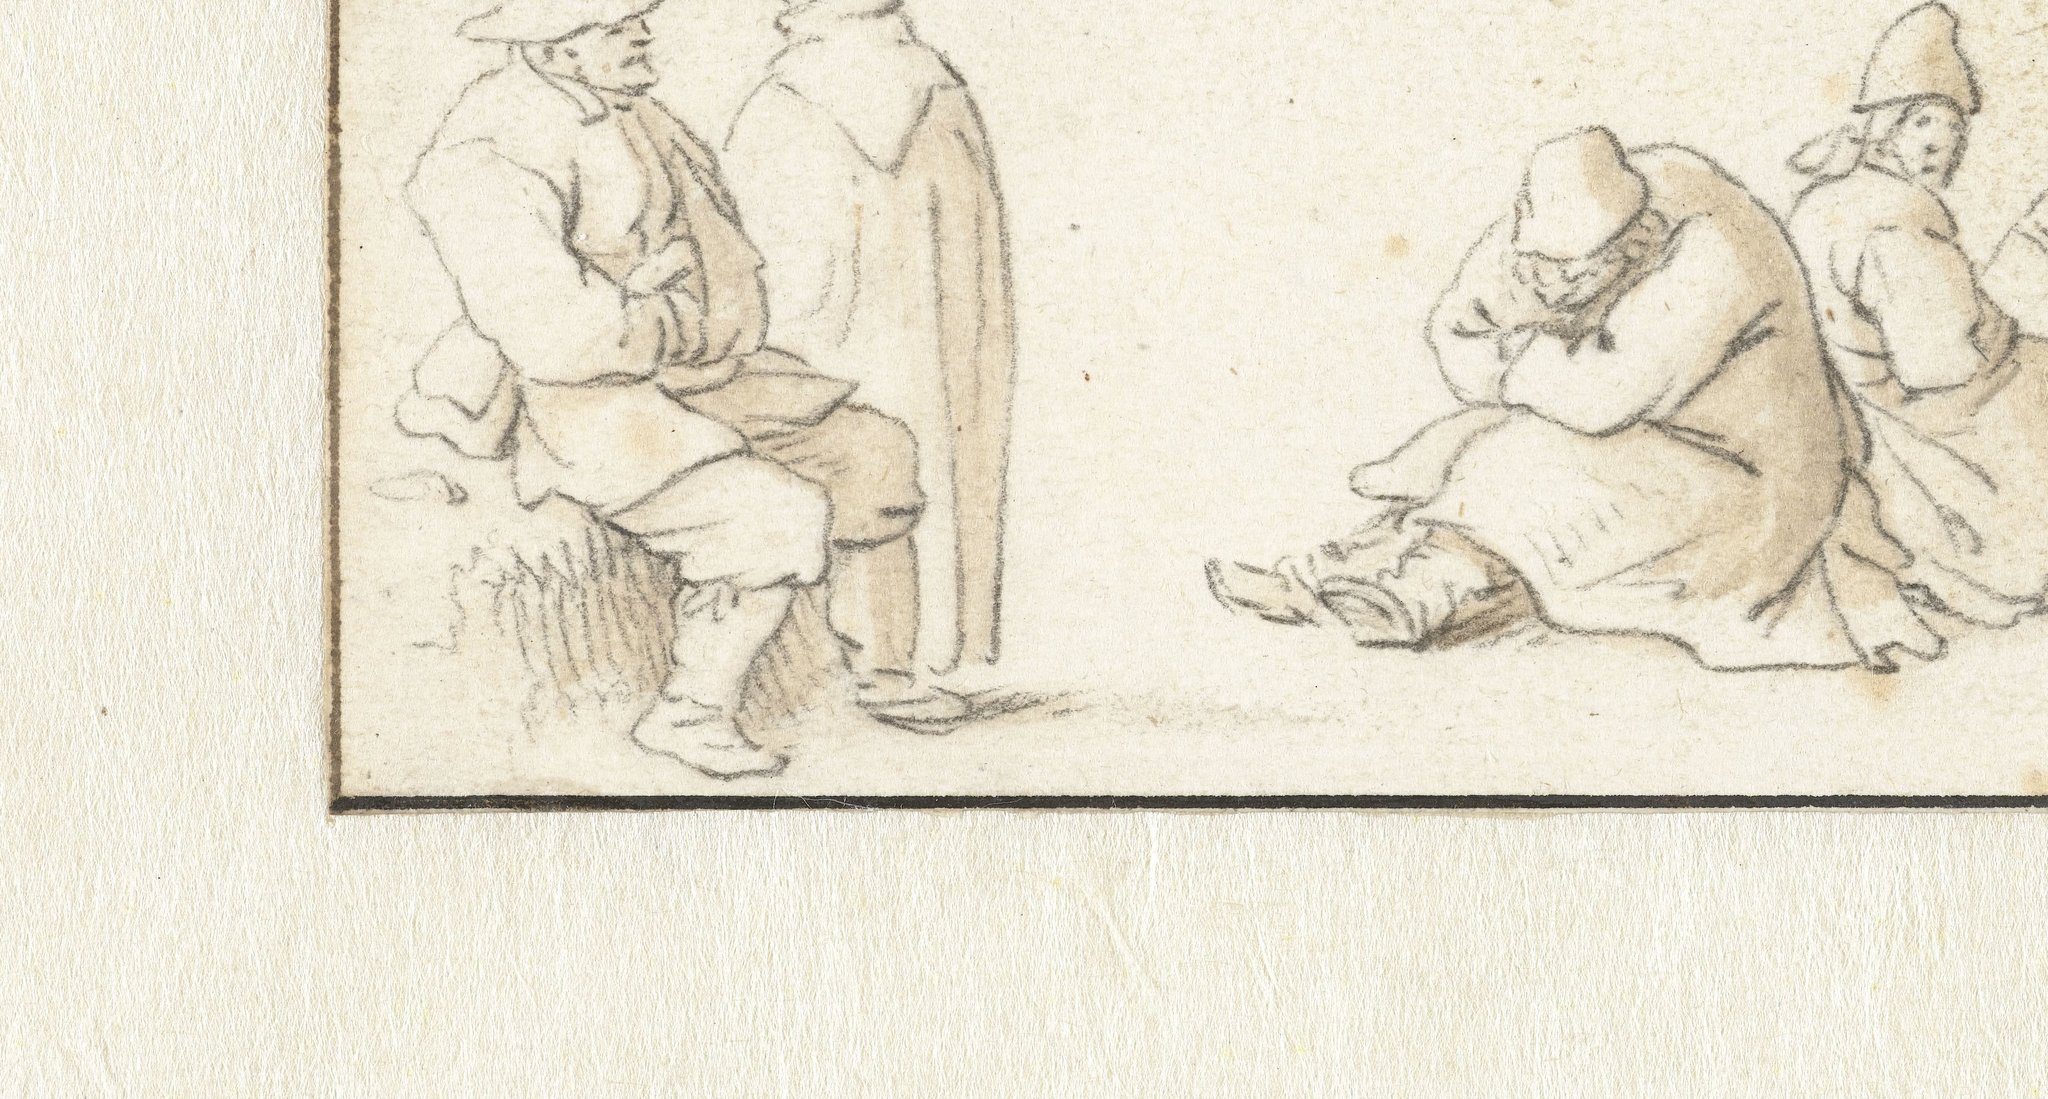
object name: drawing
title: Staande man en vier zittende mannen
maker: herman saftleven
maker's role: draughtsman, painter, print maker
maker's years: 1609-1685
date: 1619-1685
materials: chalk, paper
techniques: brush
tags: standing figure, sitting figure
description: Een staande en een zittende man, rechts drie zittende mannen.